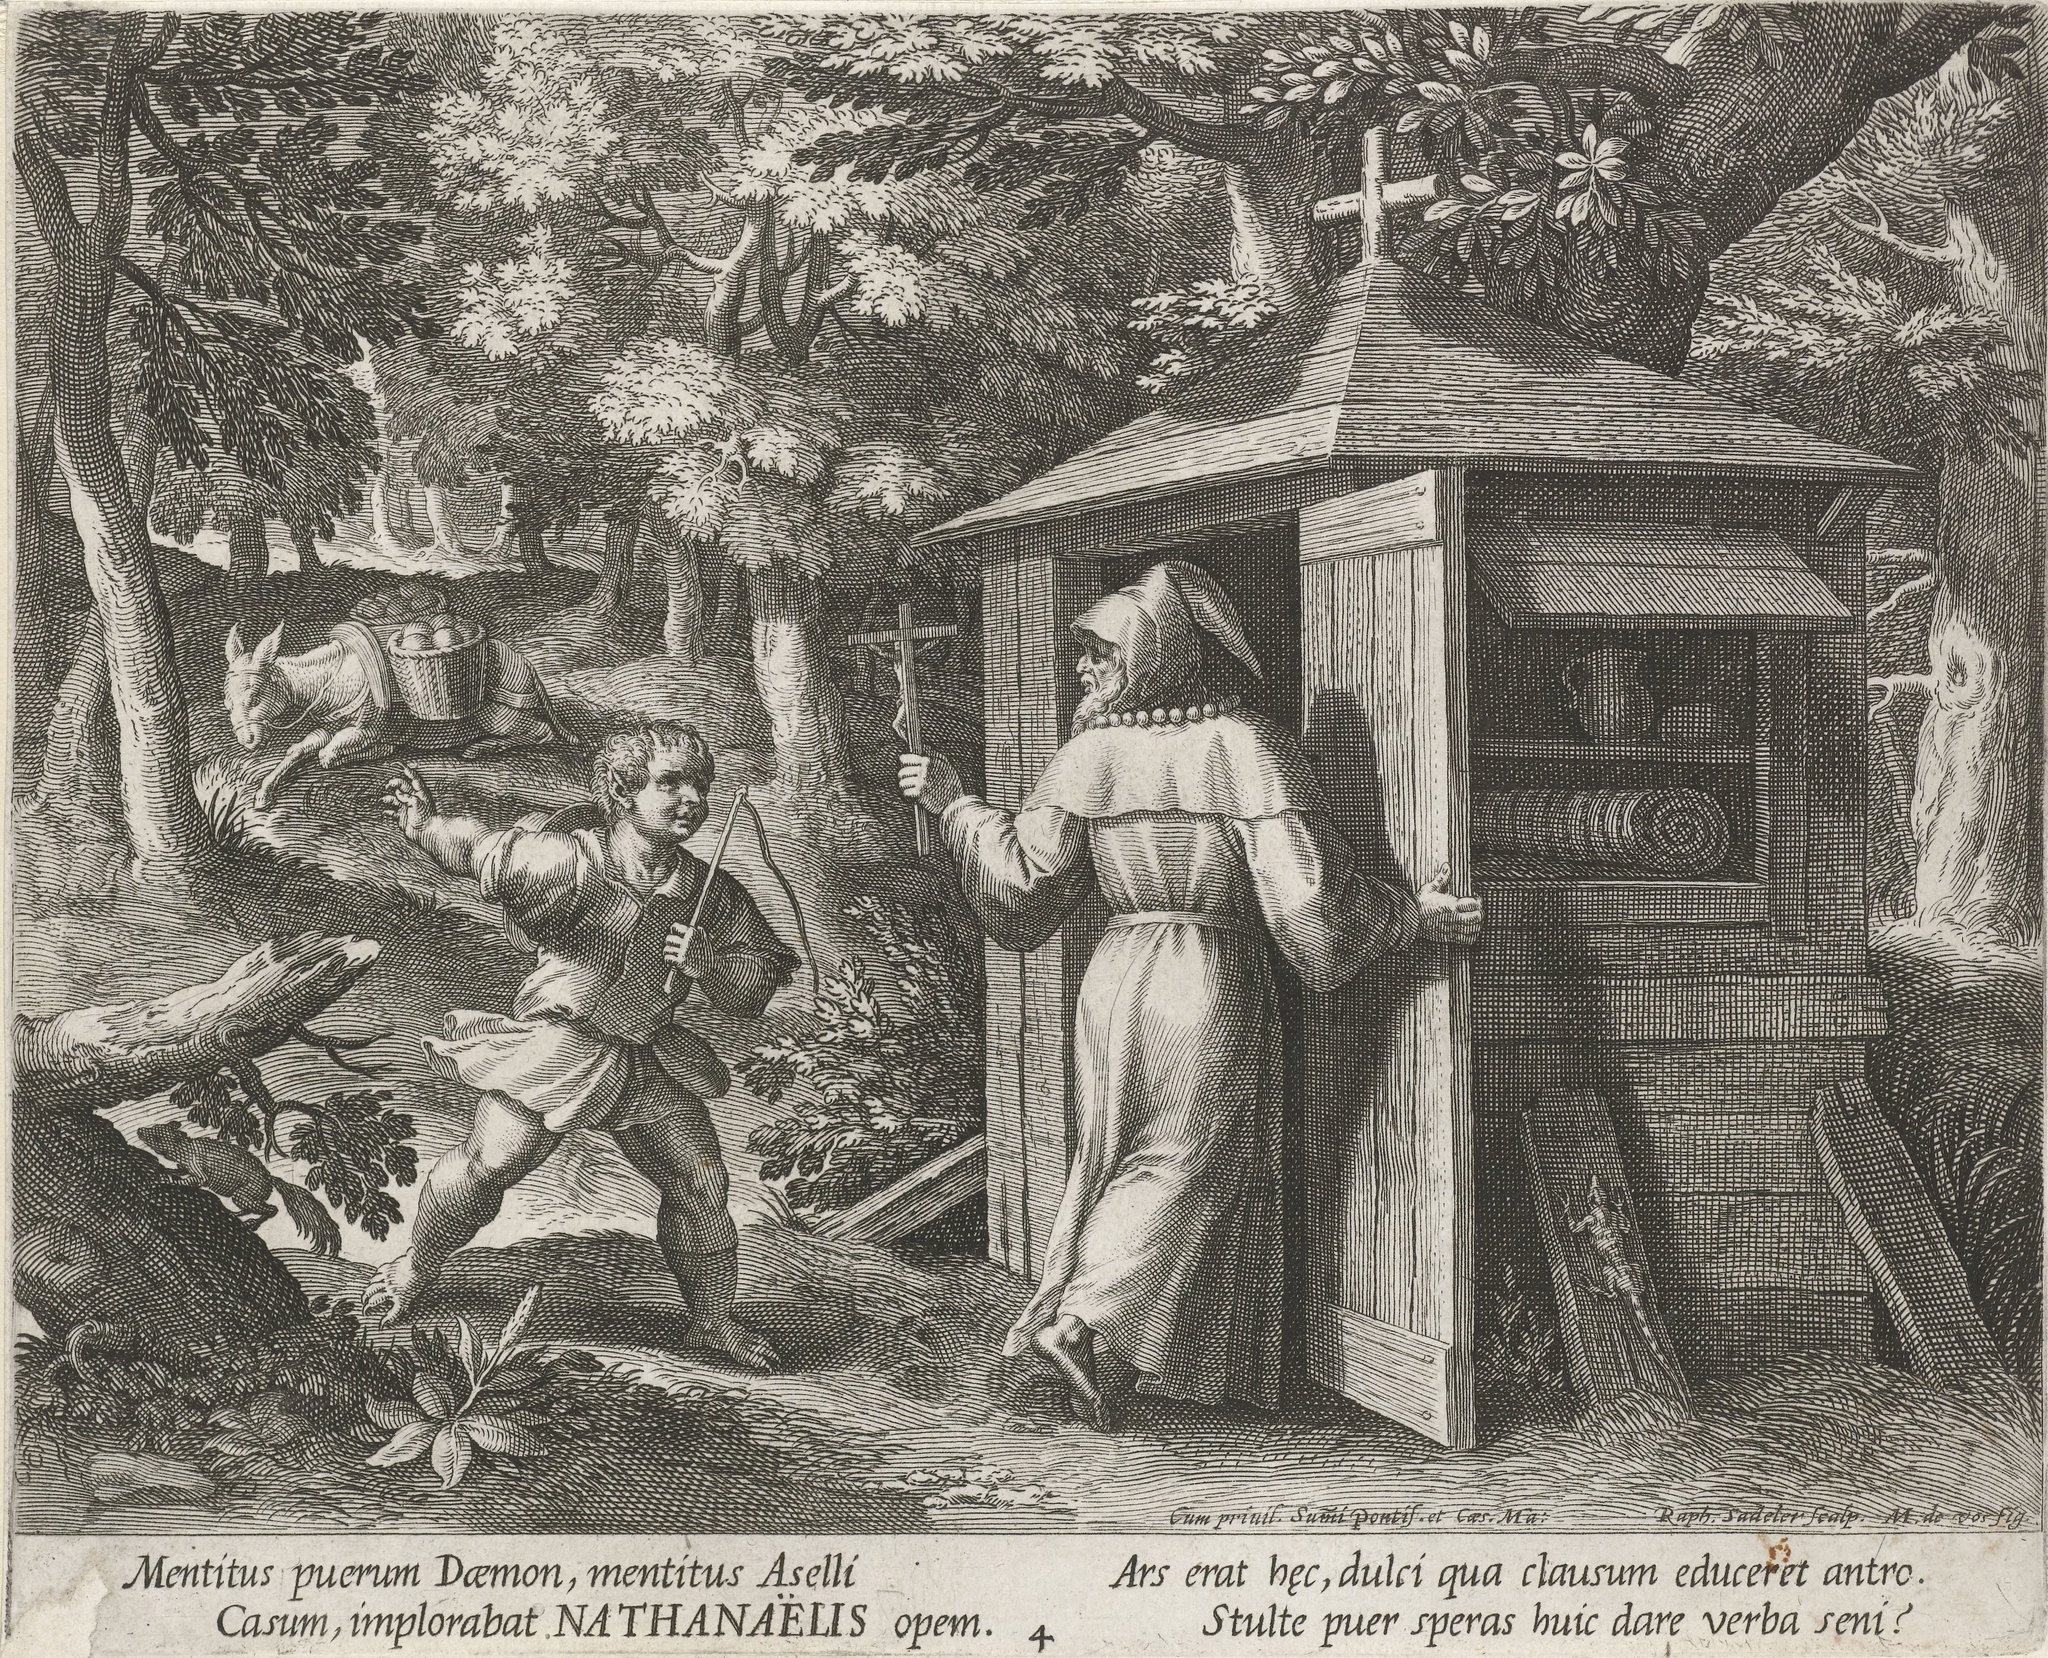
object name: print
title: Oraculum Anachoreticum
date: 1600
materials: paper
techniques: engraving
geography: venice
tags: acts of bartholomew, the apostle bartholomew; possible attributes: book, devil or dragon at feet, knife, scroll, flayed skin, staff, ass, donkey, forest, wood, anchorite, hermit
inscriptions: collector's mark: Lugt 240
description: Een boslandschap. Op de voorgrond de H. Bartholomeus, een van de apostelen. Hij wordt ook Nathanaël genoemd. Hij betreedt zijn kluizenaarshut terwijl hij de duivel, in de vorm van een jongeling met een zweep, een crucifix voorhoudt. Op de achtergrond een ezel.